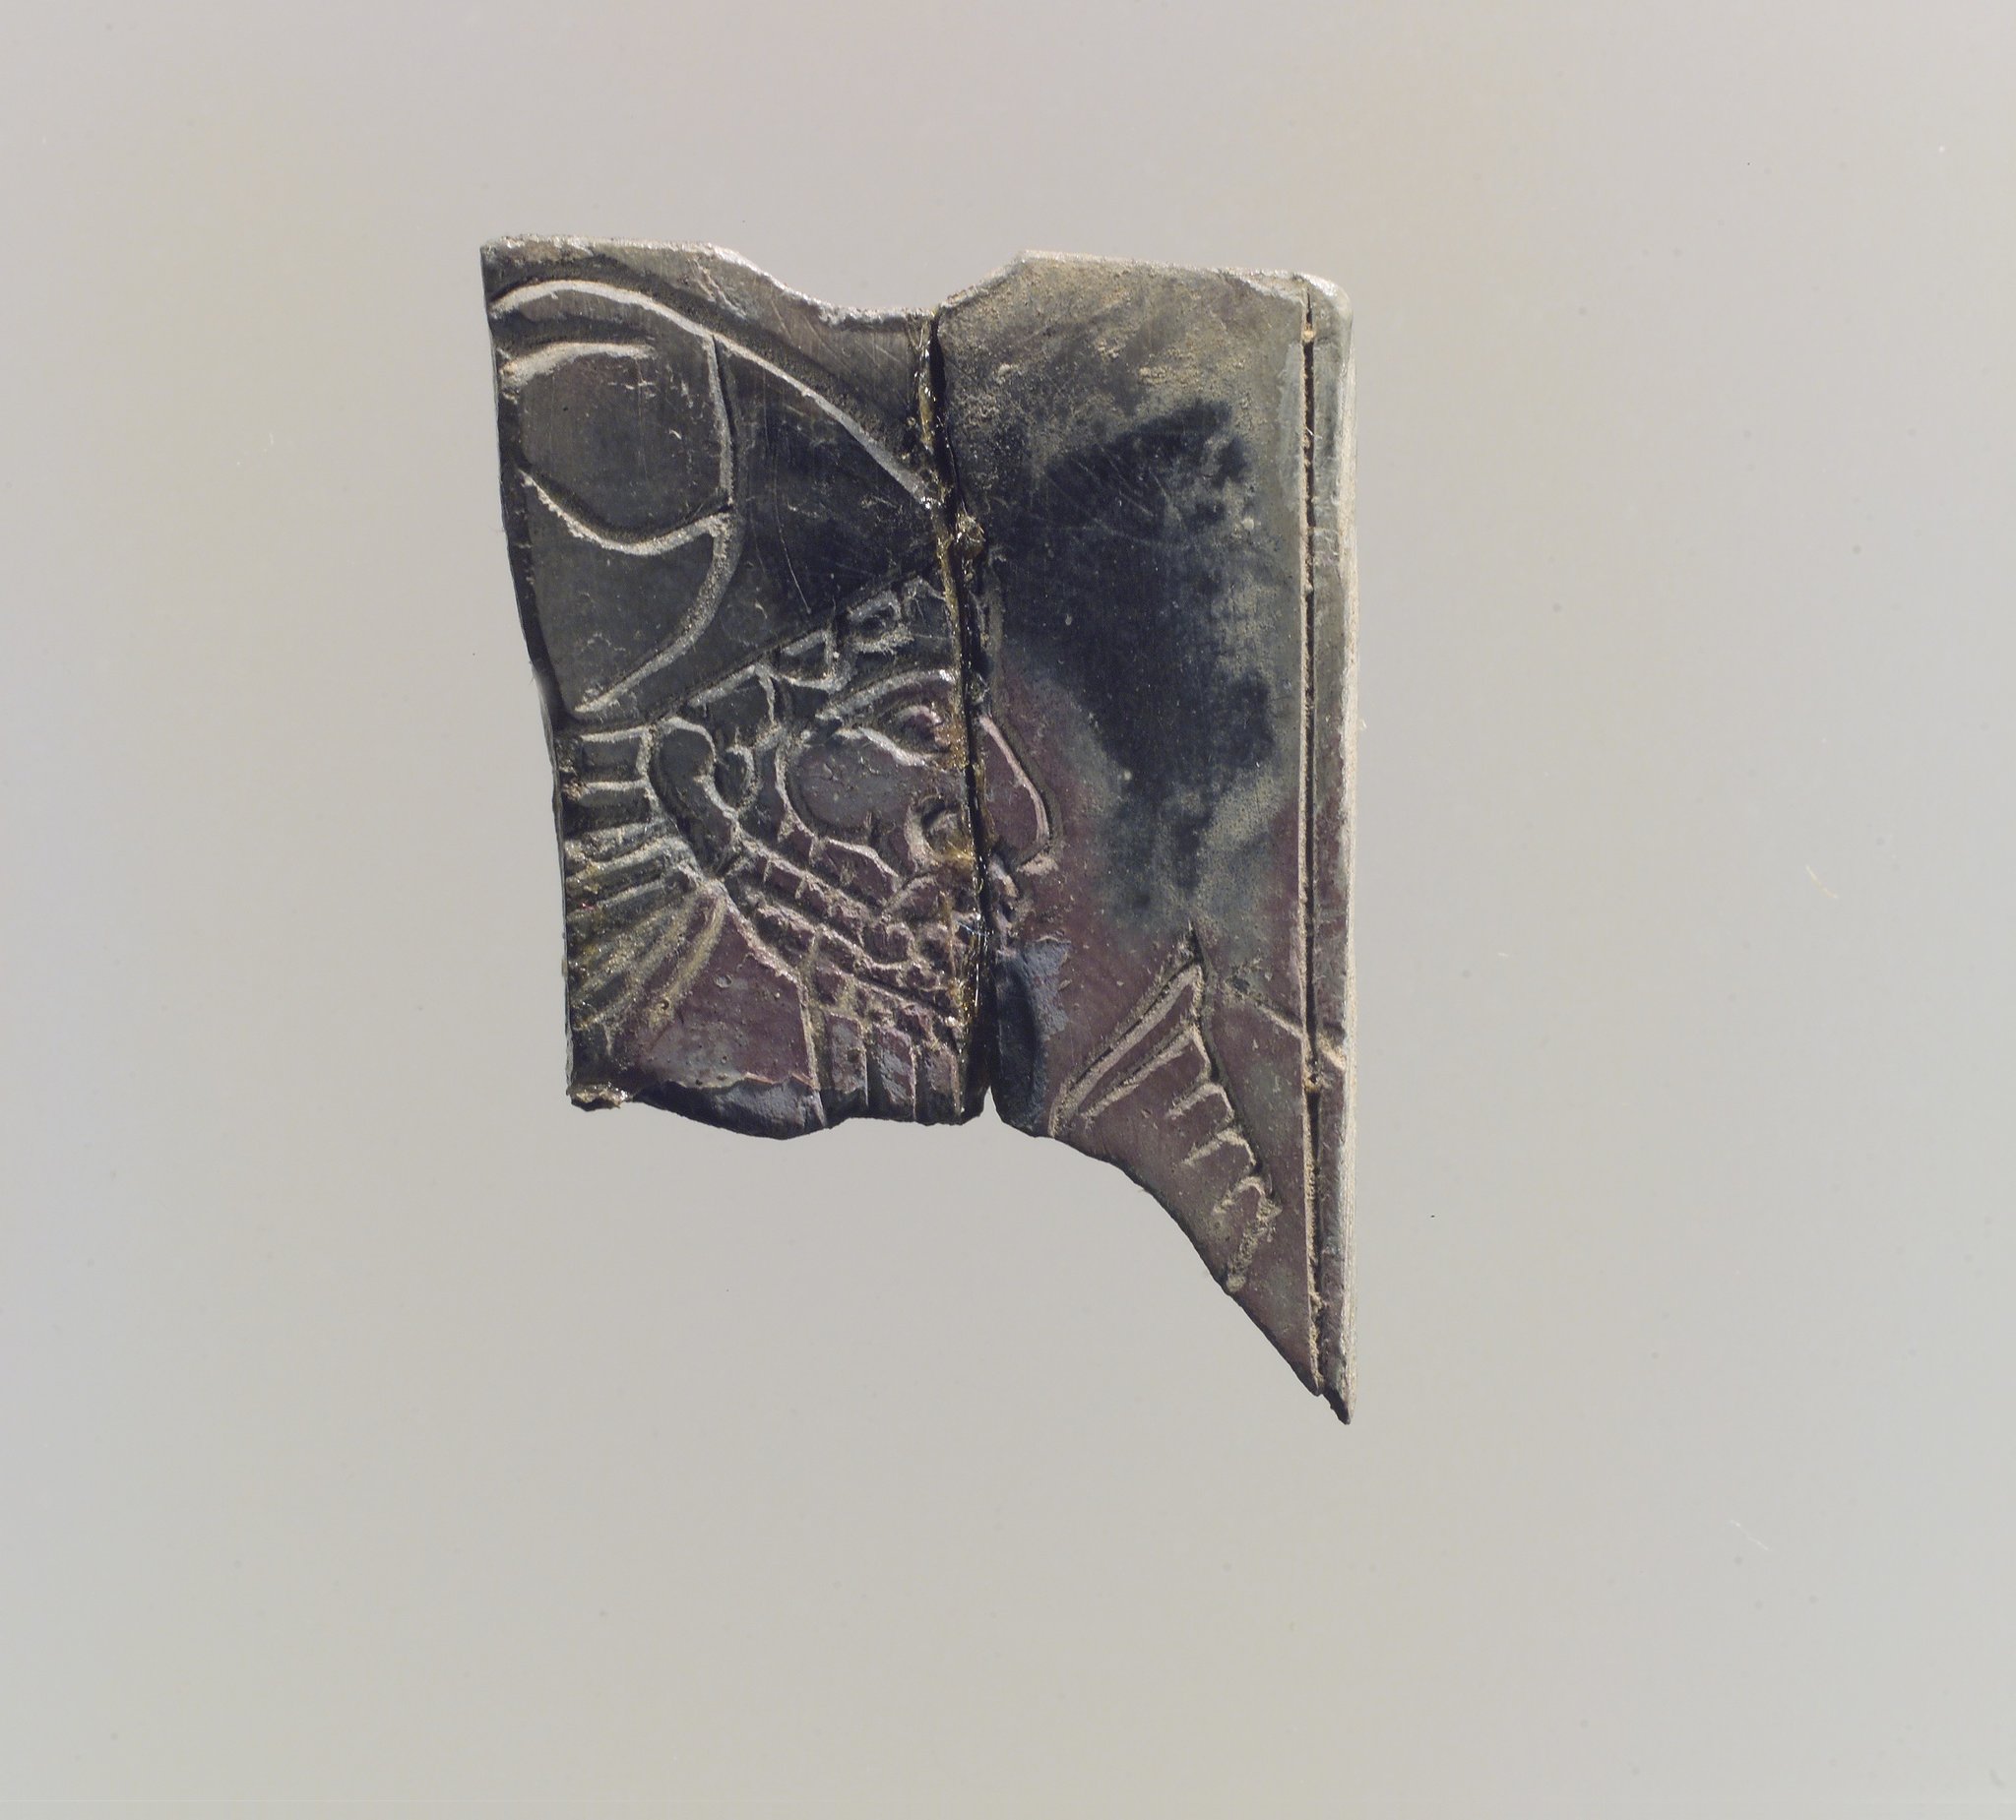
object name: relief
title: Plaque fragment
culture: assyrian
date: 900-701 BCE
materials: ivory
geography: mesopotamia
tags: faces